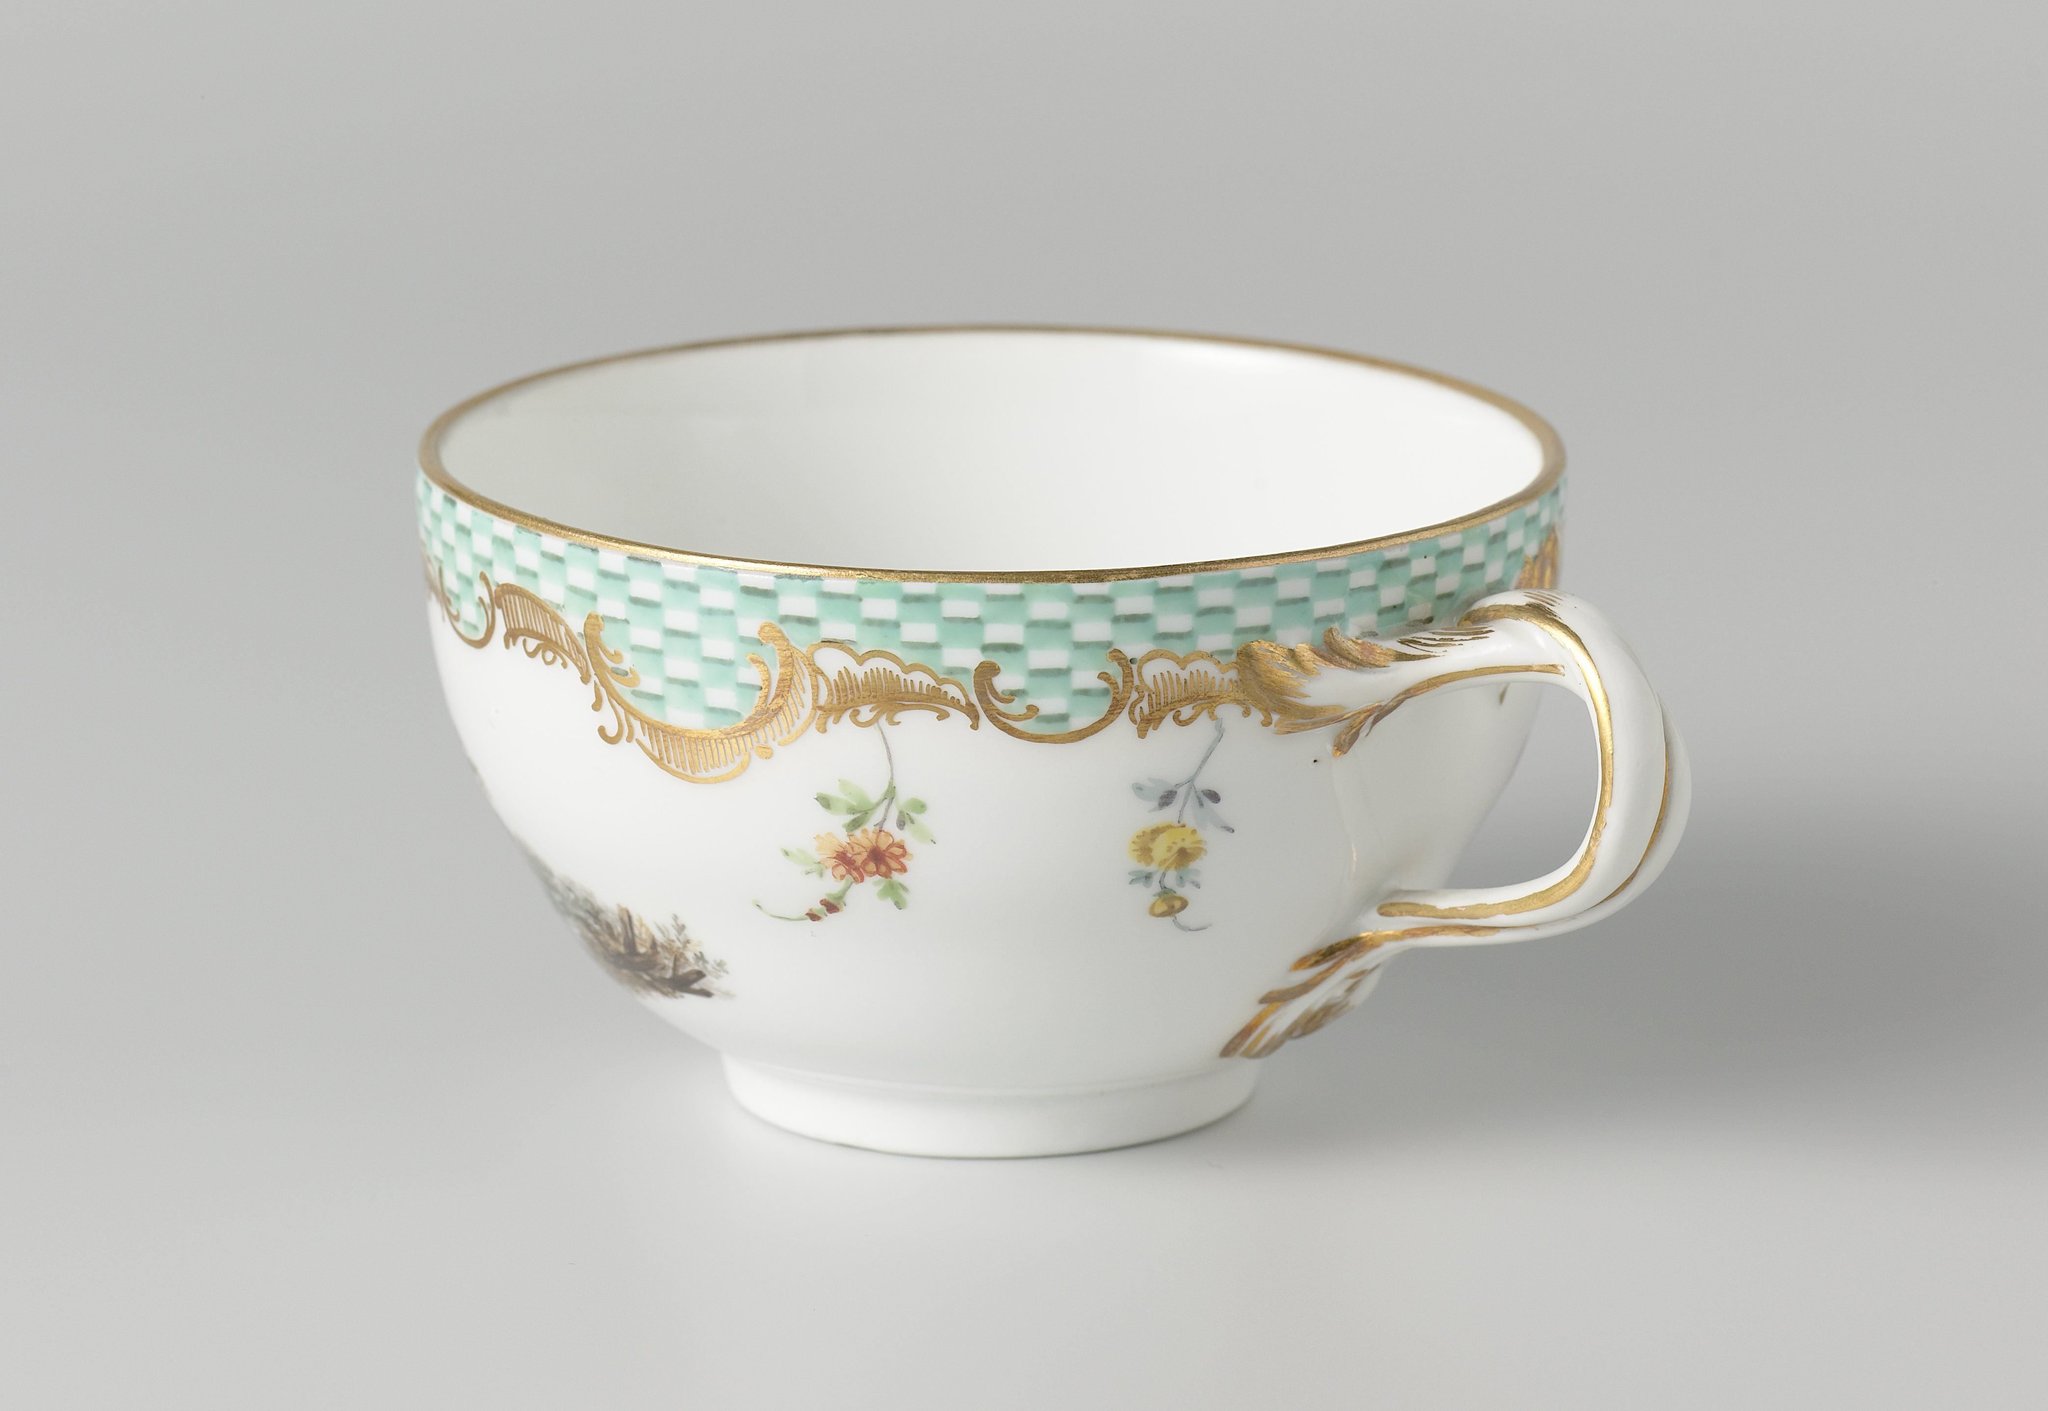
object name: cup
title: Kop, veelkleurig beschilderd met een landschap met figuren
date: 1777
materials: porcelain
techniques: painted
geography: meissen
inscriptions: mold mark: ‘F 15’, factory mark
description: Lage kop met oor, van beschilderd porselein. De kop is beschilderd met landschappen waarin figuren en langs de rand een brede strook groen vlechtwerk. De kop is gemerkt.